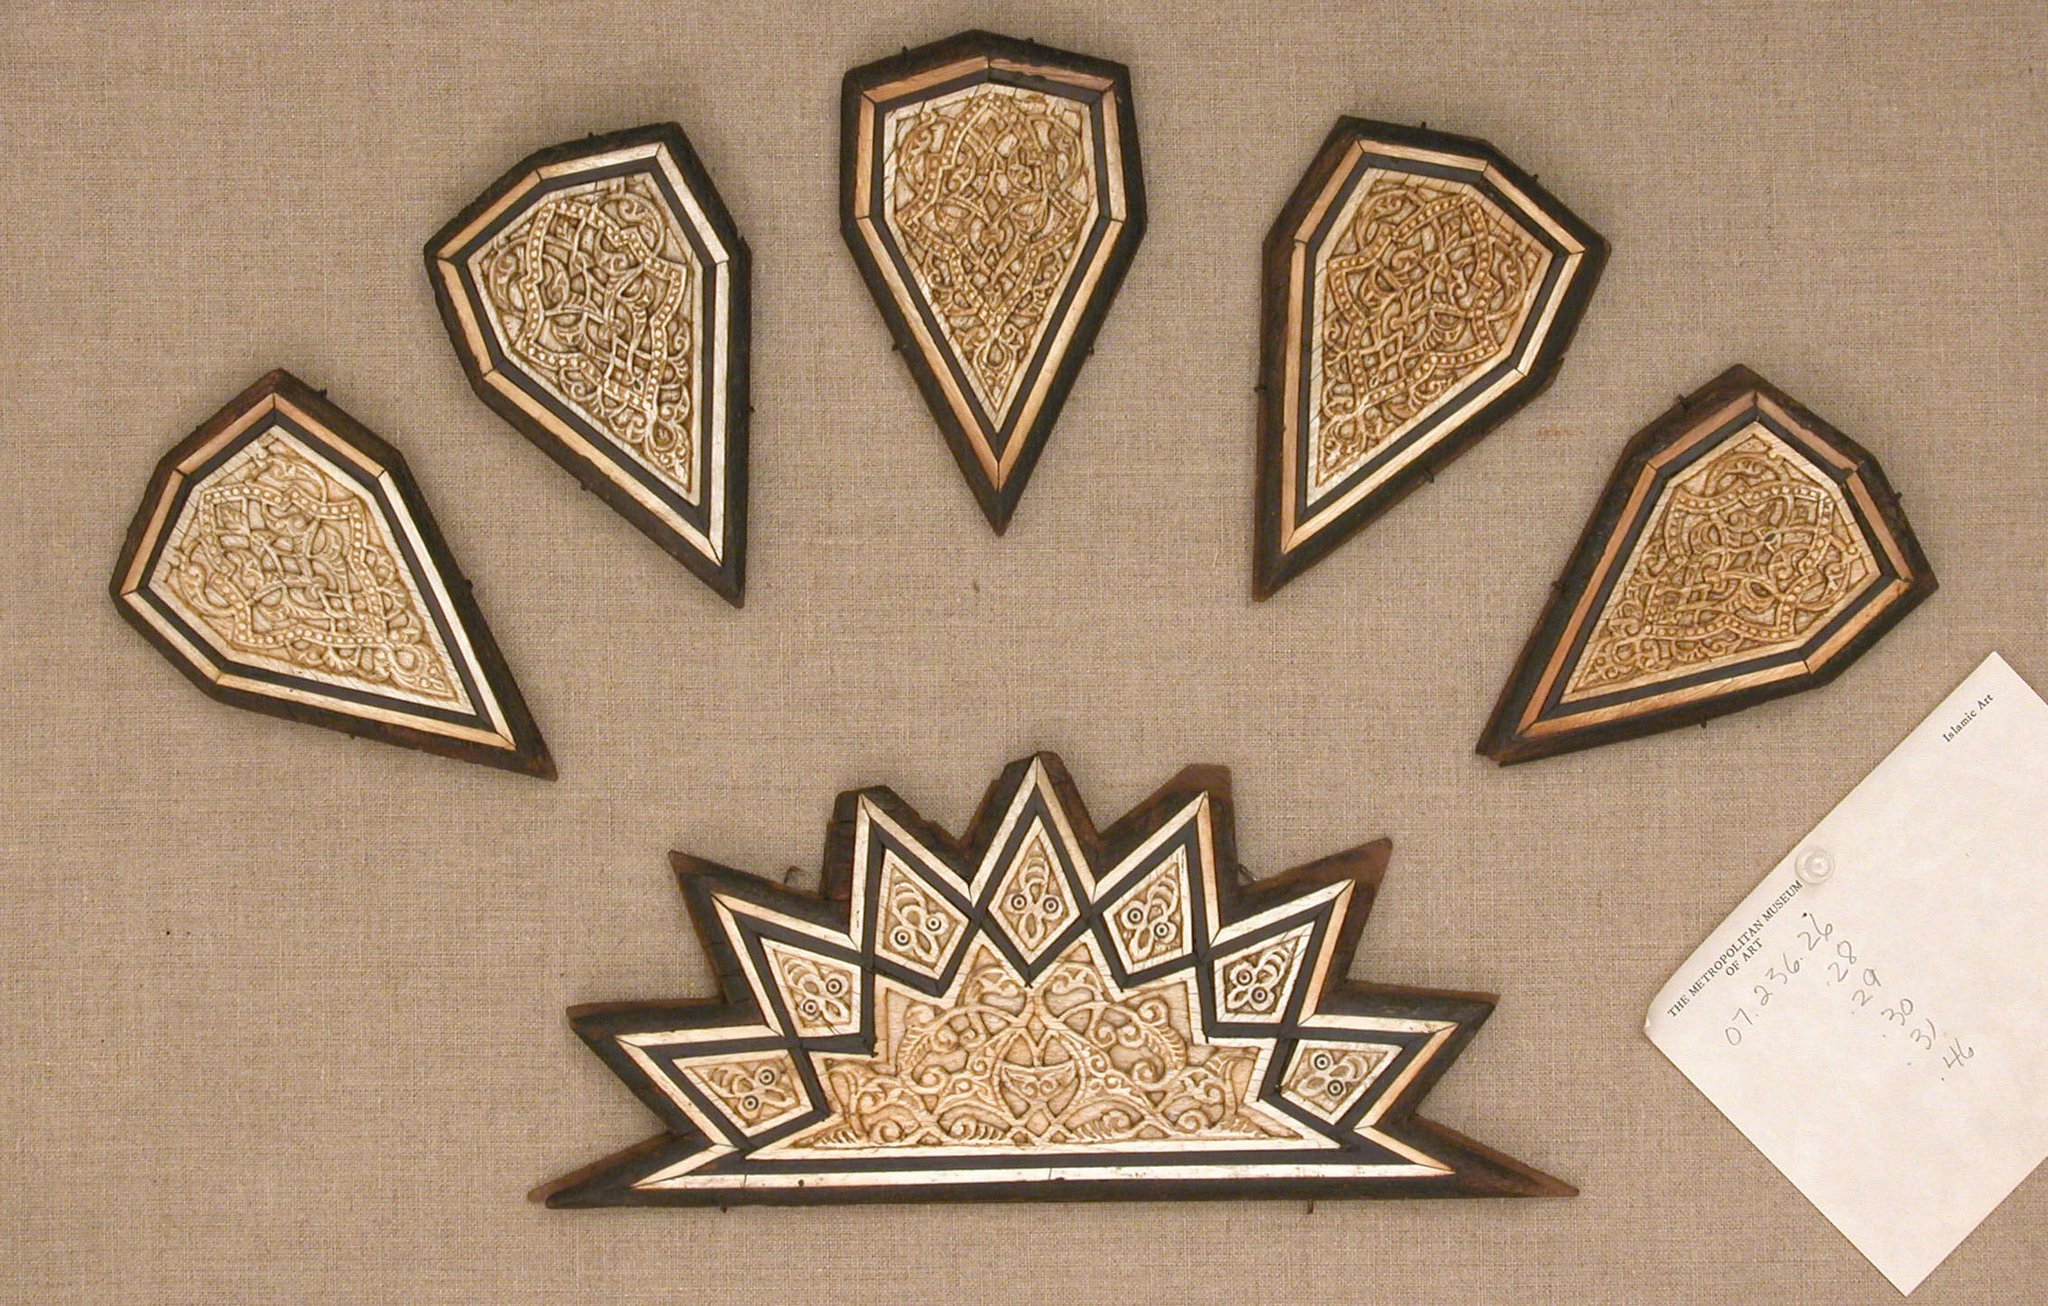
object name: panel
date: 1201-1300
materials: ivory, wood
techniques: carving, inlay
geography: egypt